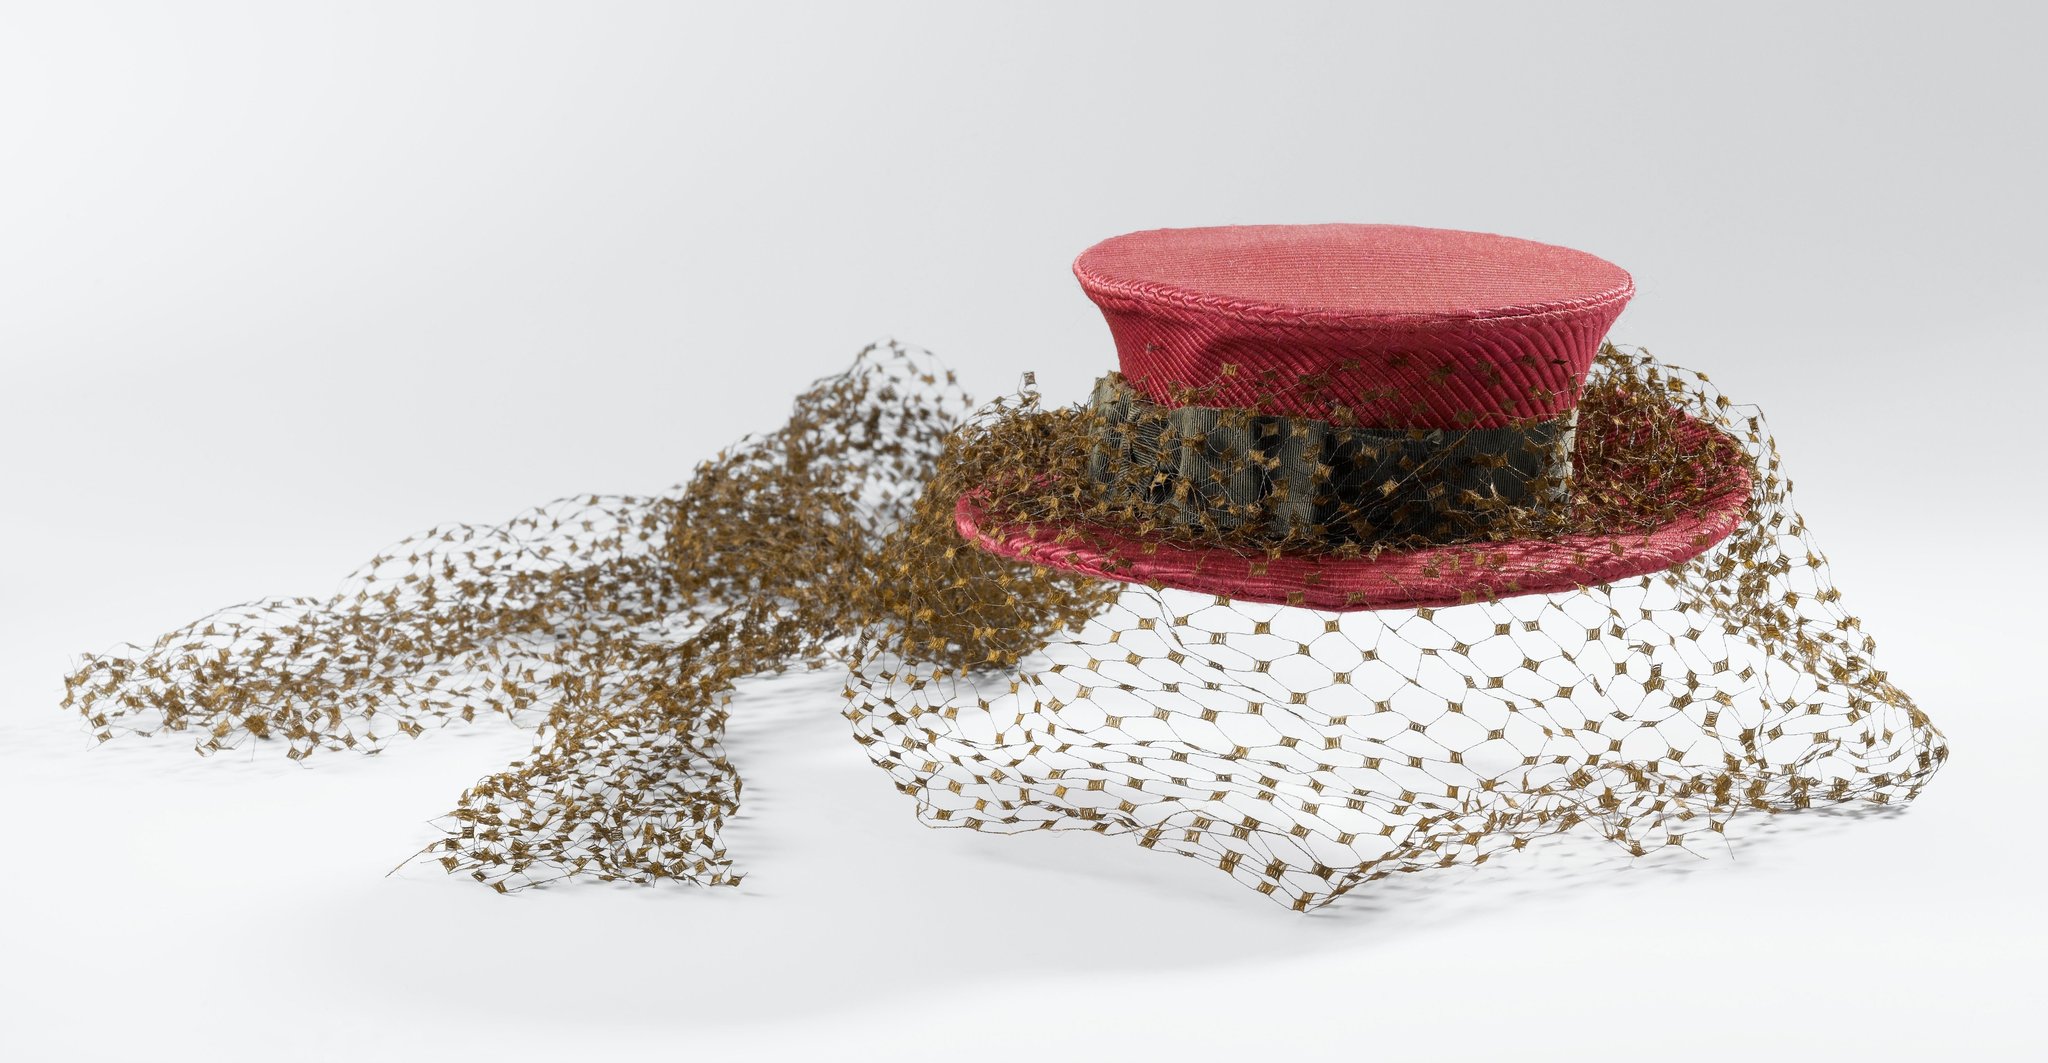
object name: womenswear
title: Kleine hoed van doorgestikte rode ripszijde met platte bol en licht opstaande rand, versierd met bruin grosgrain en bruine voile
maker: rose valois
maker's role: modiste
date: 1941-1942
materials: textile, rib, fiber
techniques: quilting, weave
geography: paris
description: Kleine hoed van doorgestikte rode ripszijde met platte bol en licht opstaande rand, versierd met bruin grosgrain en bruine voile. Model: losse bol en rand. De bol, die van boven naar beneden taps toeloopt, bestaat uit twee delen met een naad rondom. De bol is verstevigd met paardenhaar, de rand met laiton. In de rand een naad middenachter. Ongevoerd. Bruin ripslint. Versiering: rond de bol een 3 cm breed lint van bruin grosgrain, dat rechts gestrikt is in een dubbele platte strik. Aan de voorkant een grofmazige voile, aan de achterkant een afhangende strook van dezelfde tule.